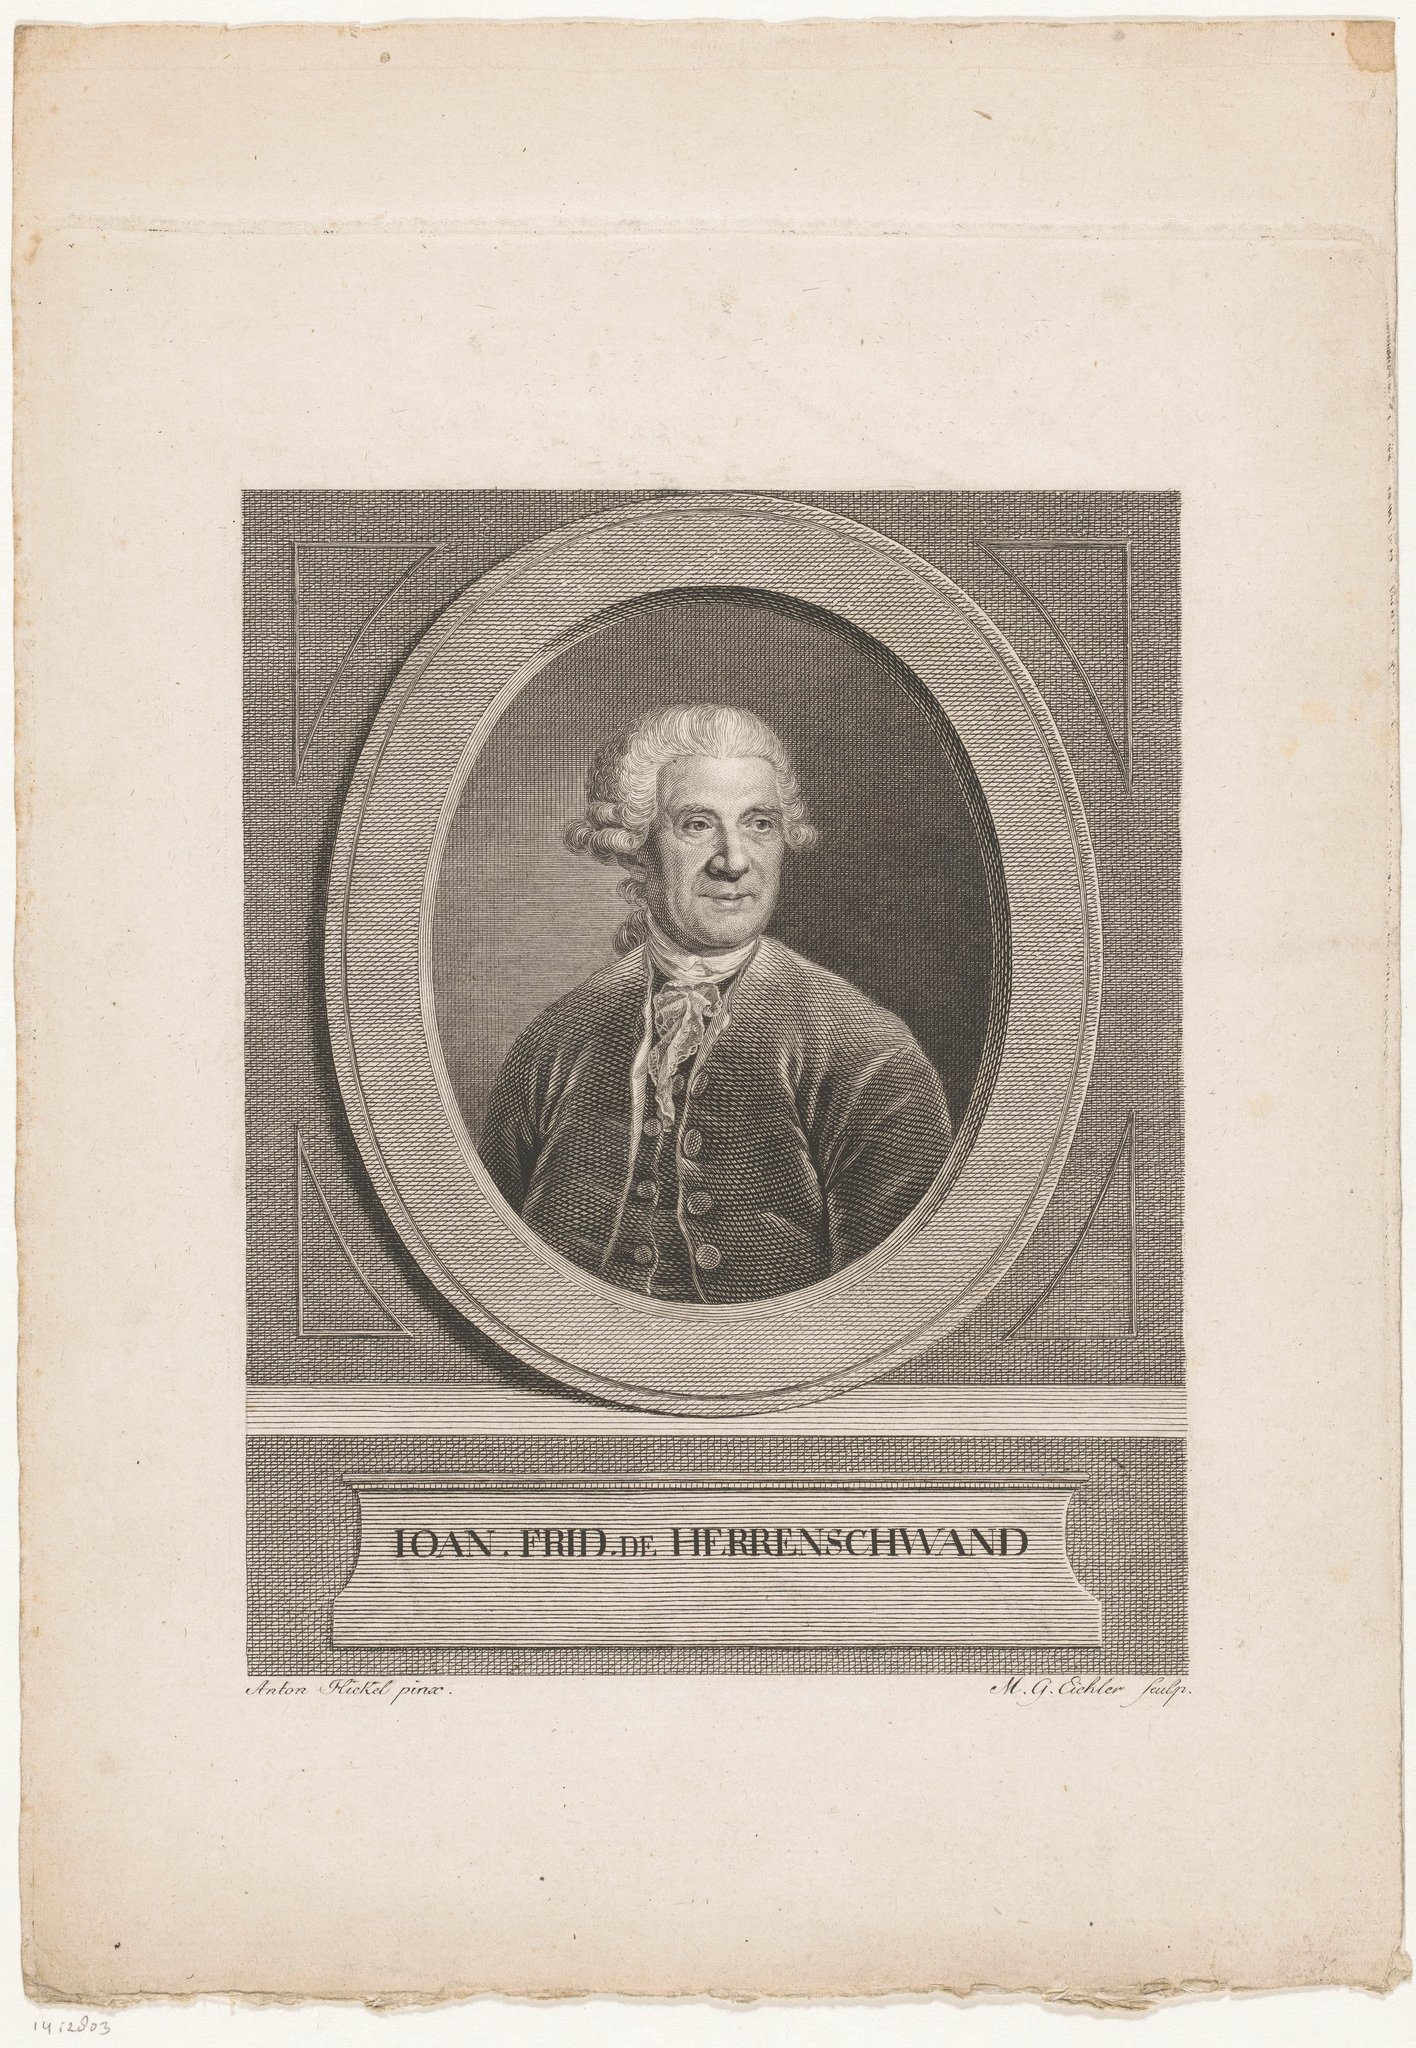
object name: print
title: Portret van Johann Friedrich Herrenschwand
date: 1758-1818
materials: paper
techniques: engraving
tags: historical persons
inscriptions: collector's mark: Lugt 2228